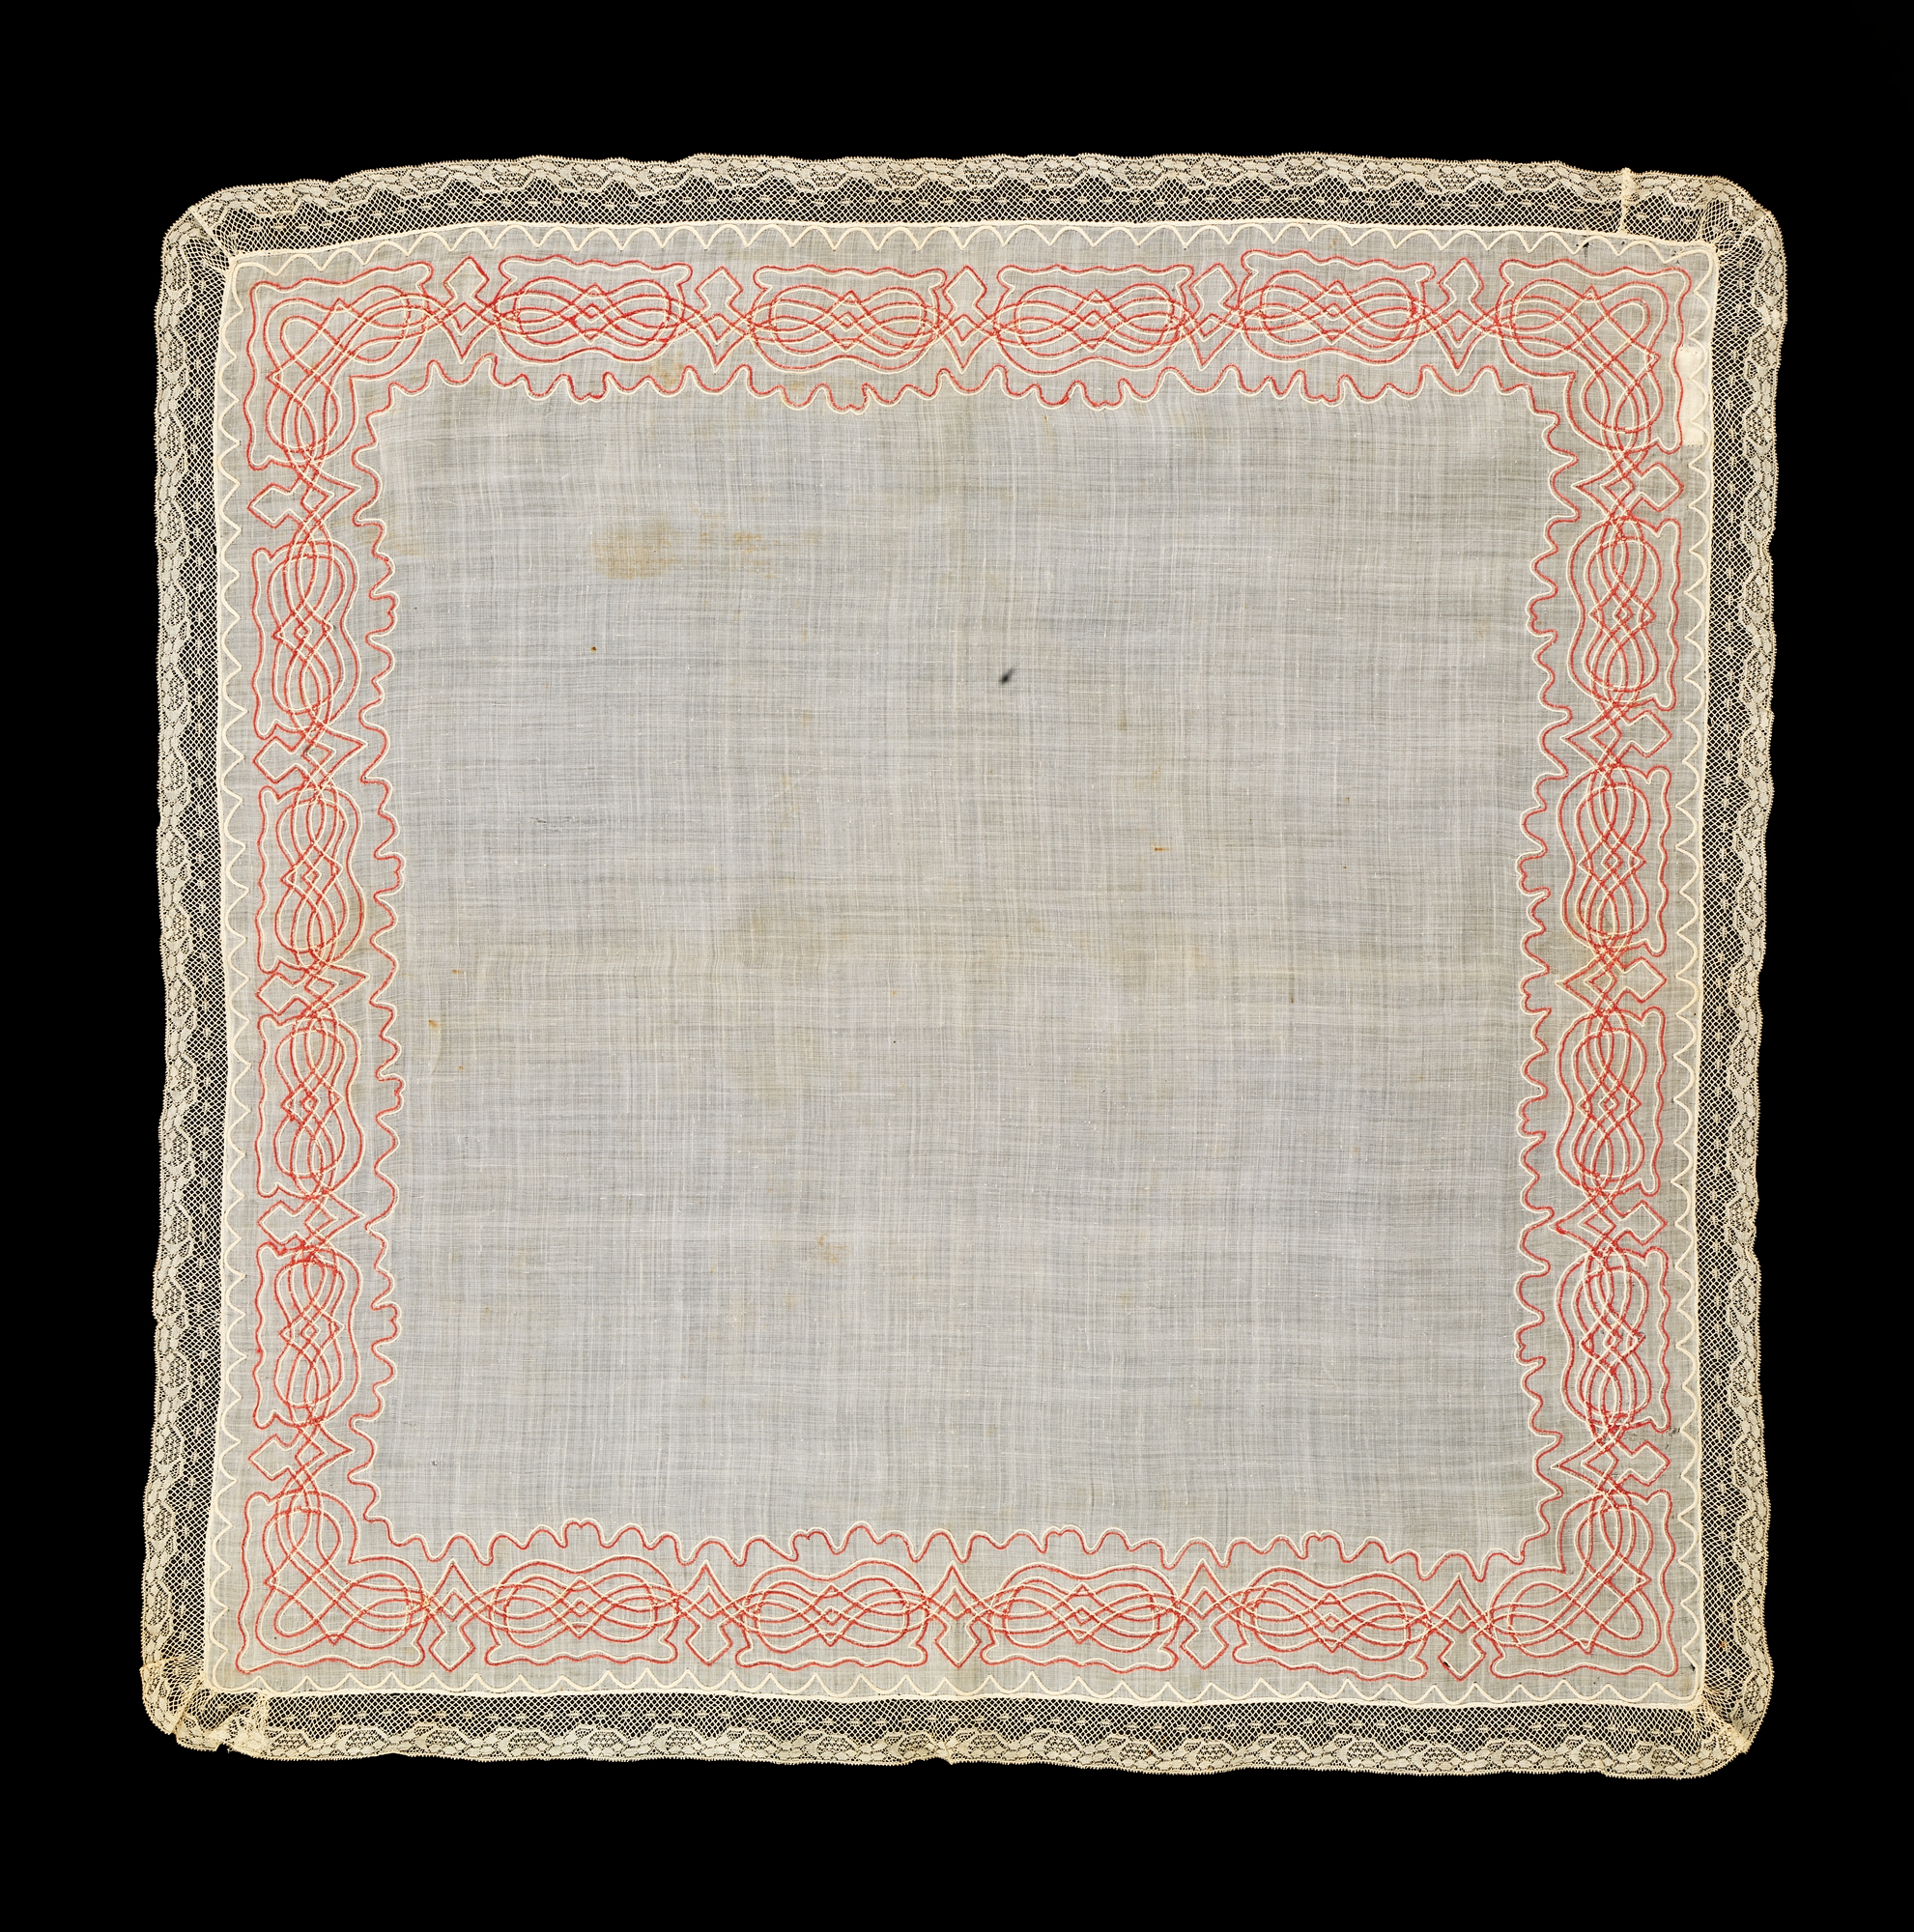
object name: handkerchief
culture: russian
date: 1860-1880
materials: linen